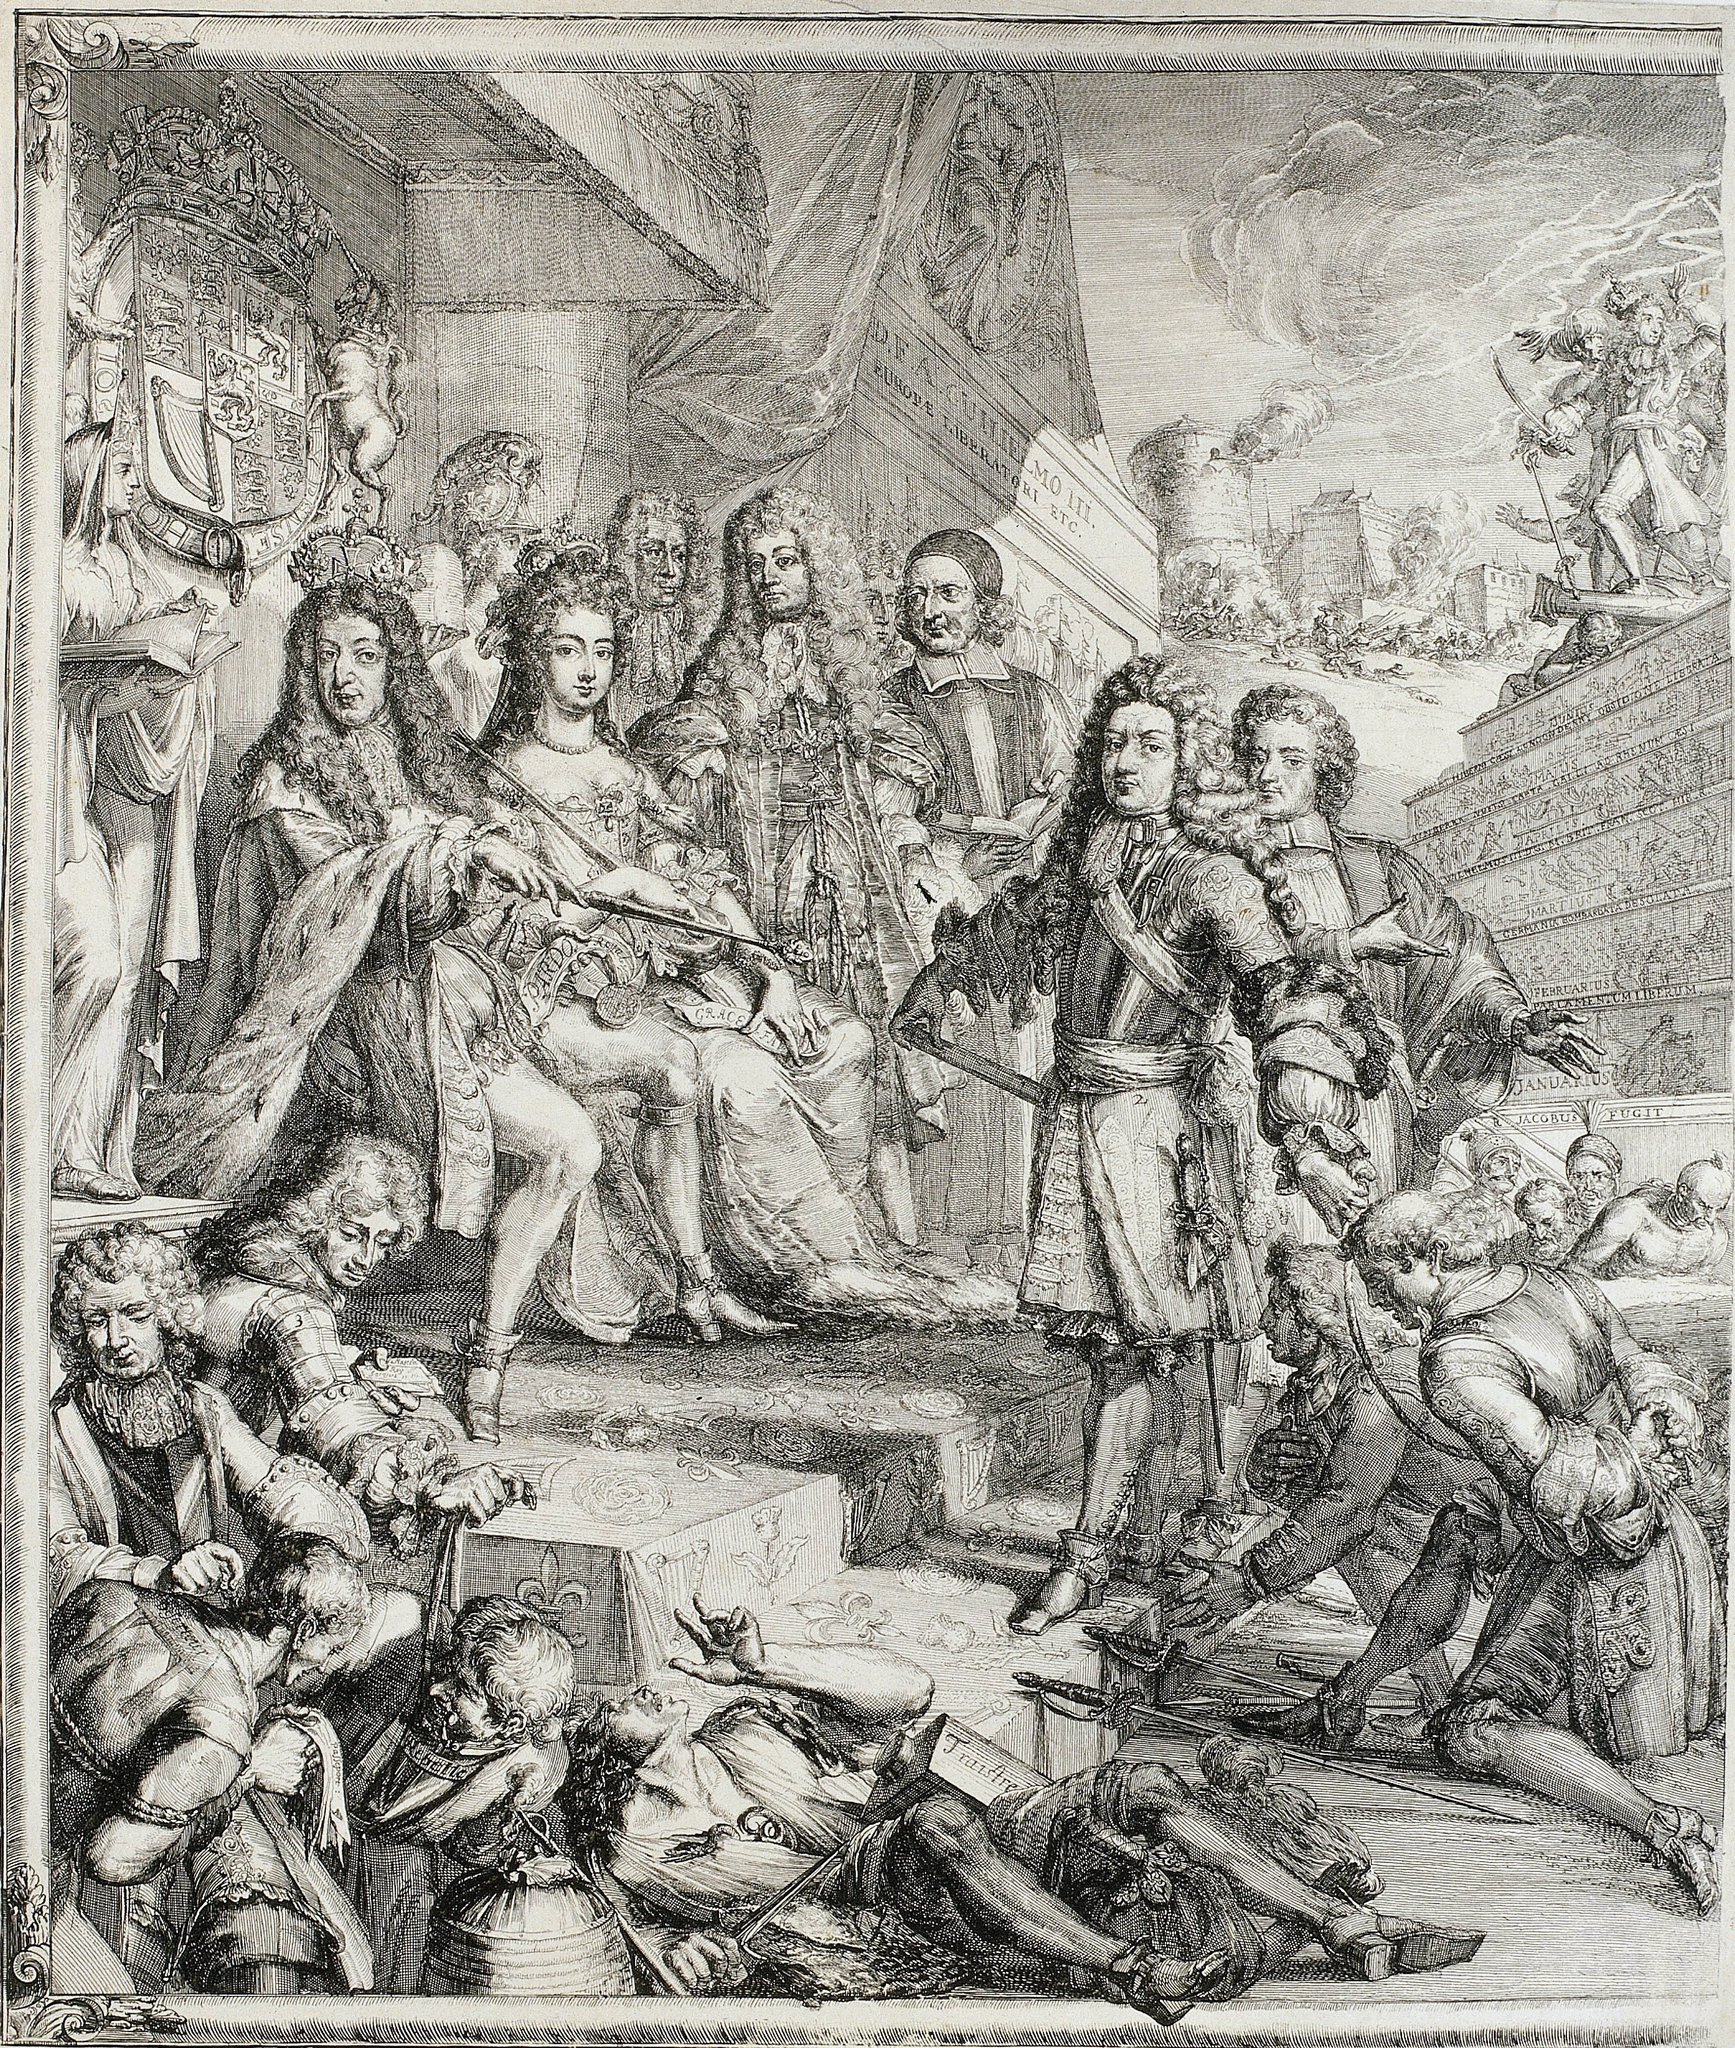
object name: print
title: Allegorie op de gebeurtenissen in 1689 met Willem III en Maria op de troon (linker helft)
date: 1690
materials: paper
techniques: etching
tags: jacobus ii (koning van engeland en schotland), william iii (prince of orange and king of england, scotland, and ireland), london, maria ii stuart (koningin van engeland, schotland en ierland)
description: Allegorie op de gebeurtenissen in 1689 met de stadhouder-koning Willem III en koningin Maria op de troon. Linker helft van twee bladen die samen één voorstelling vormen. Voor Willem en Maria staat de hertog van Schomberg met twee knielende overwonnen Ierse generaals aan wie door de koning en koningin gratie wordt verleend. Links vooraan drie gevangen genomen personificaties van Verraad, Rebellie en Desertie. Rechts de helft van een piramide met de gebeurtenissen van de eerste zes maanden. Bovenaan valt Jacobus II van de piramide. Sommige elementen in de voorstelling aangeduid met cijfers.